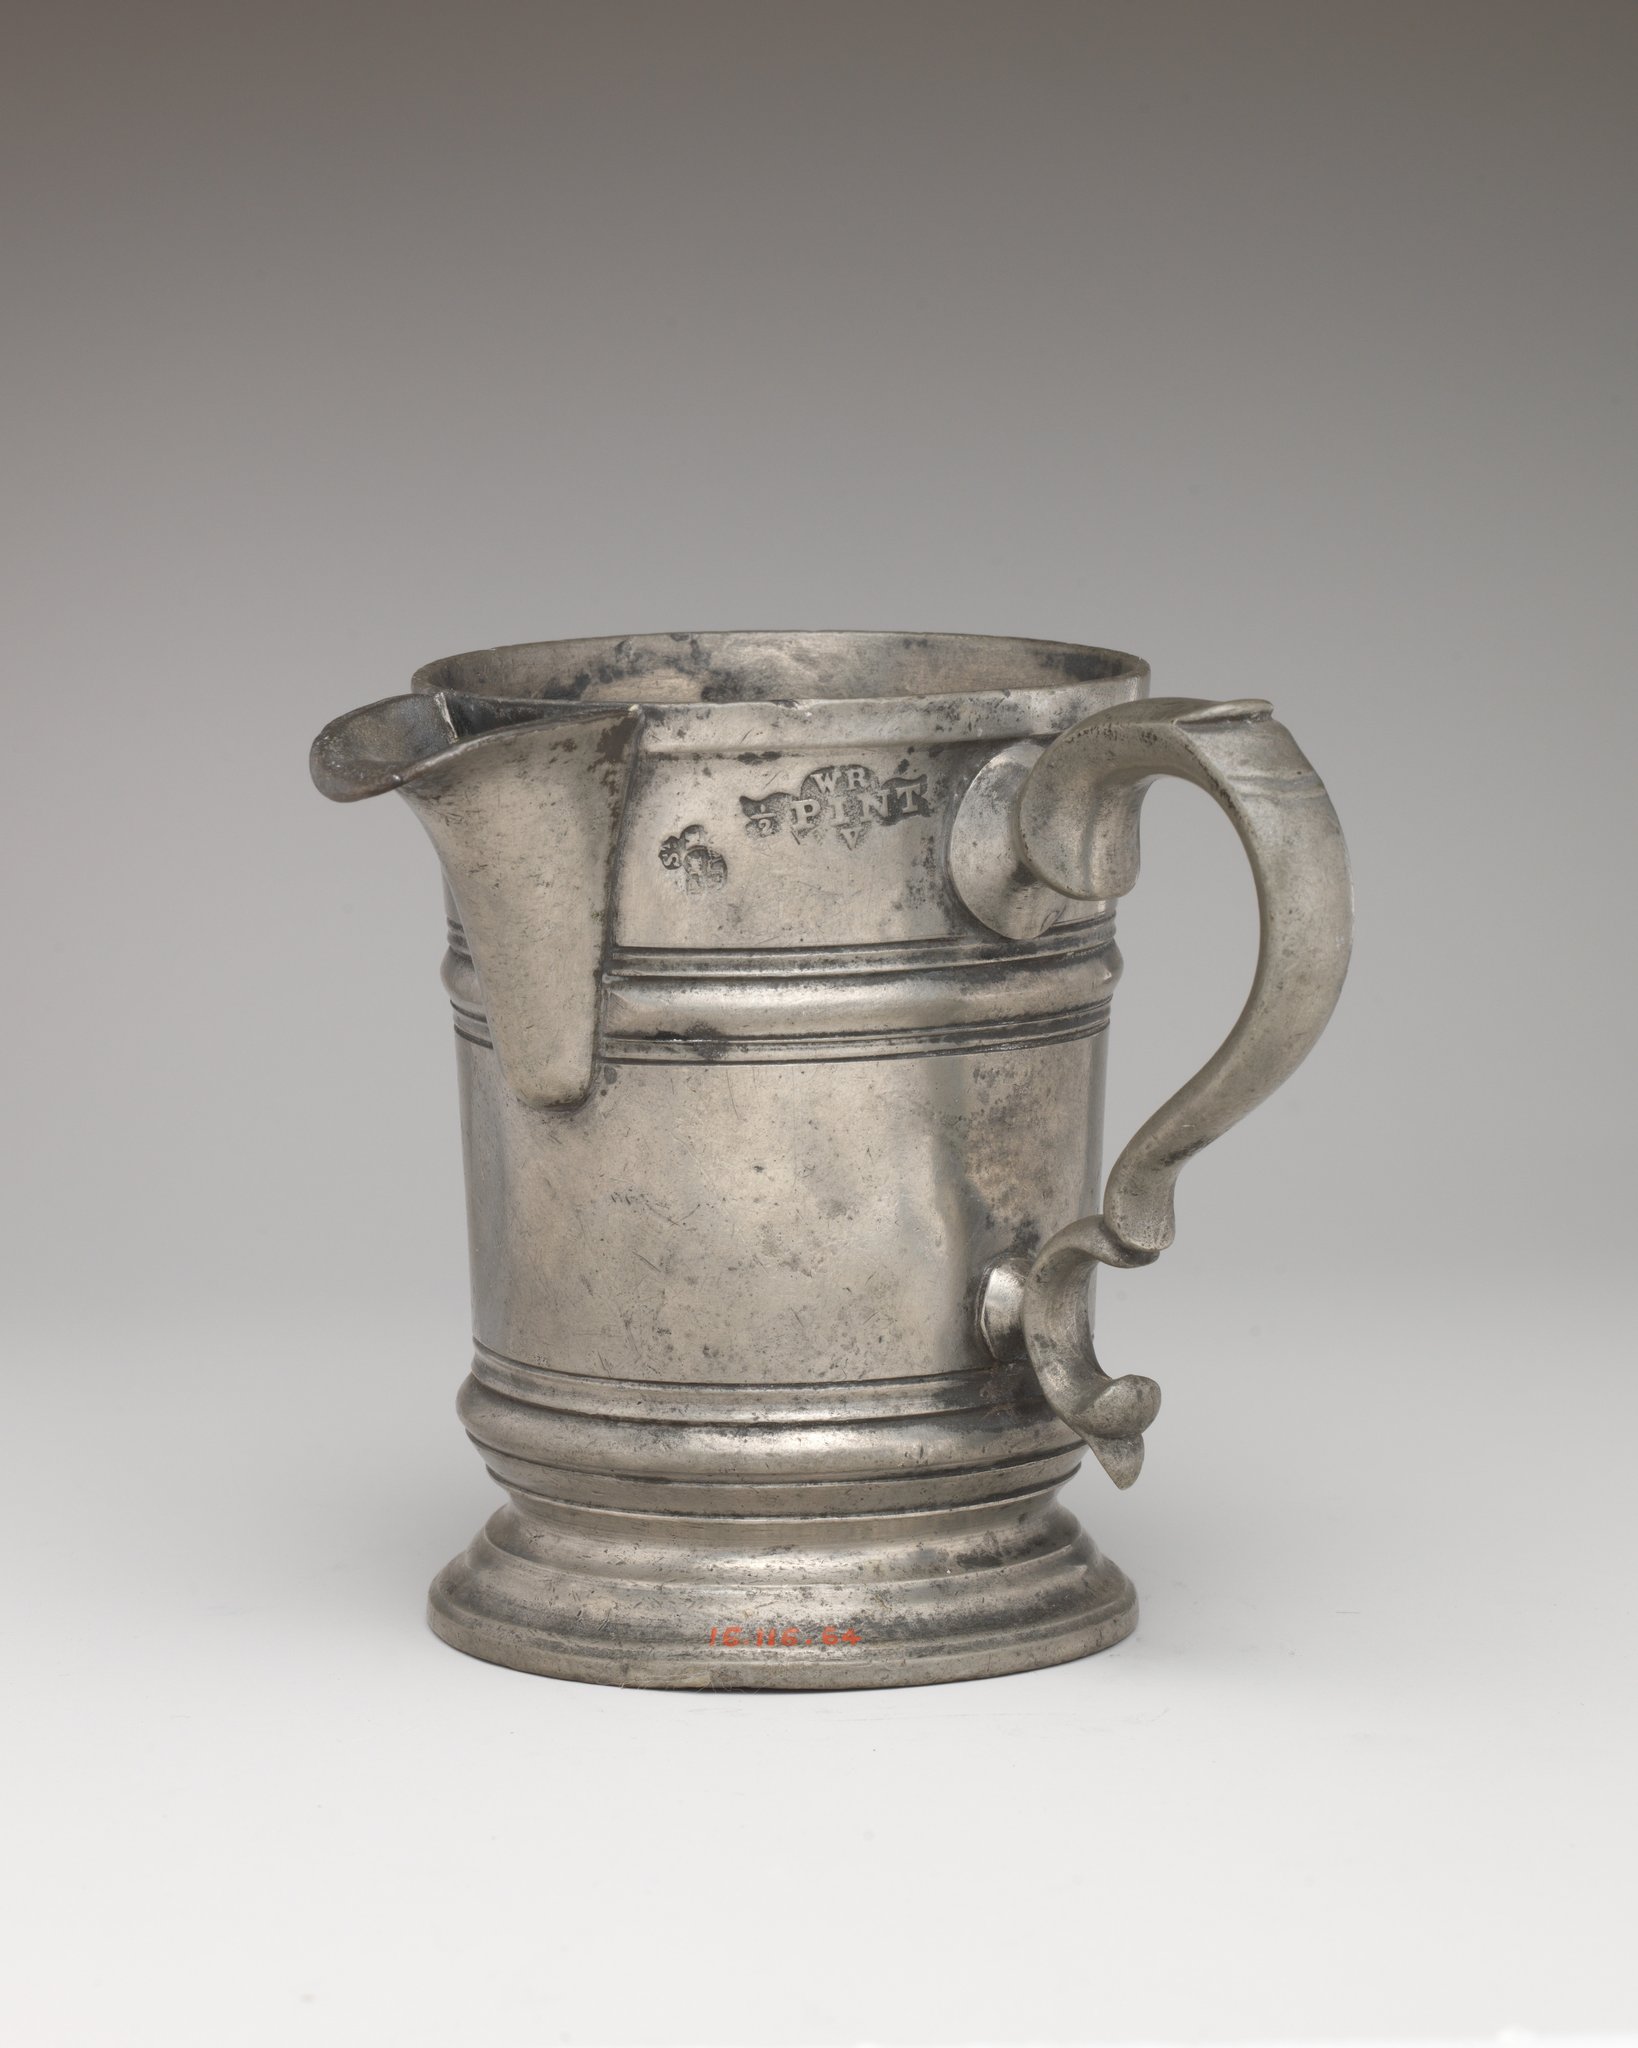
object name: measure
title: Half Pint Measure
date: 1801-1900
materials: pewter